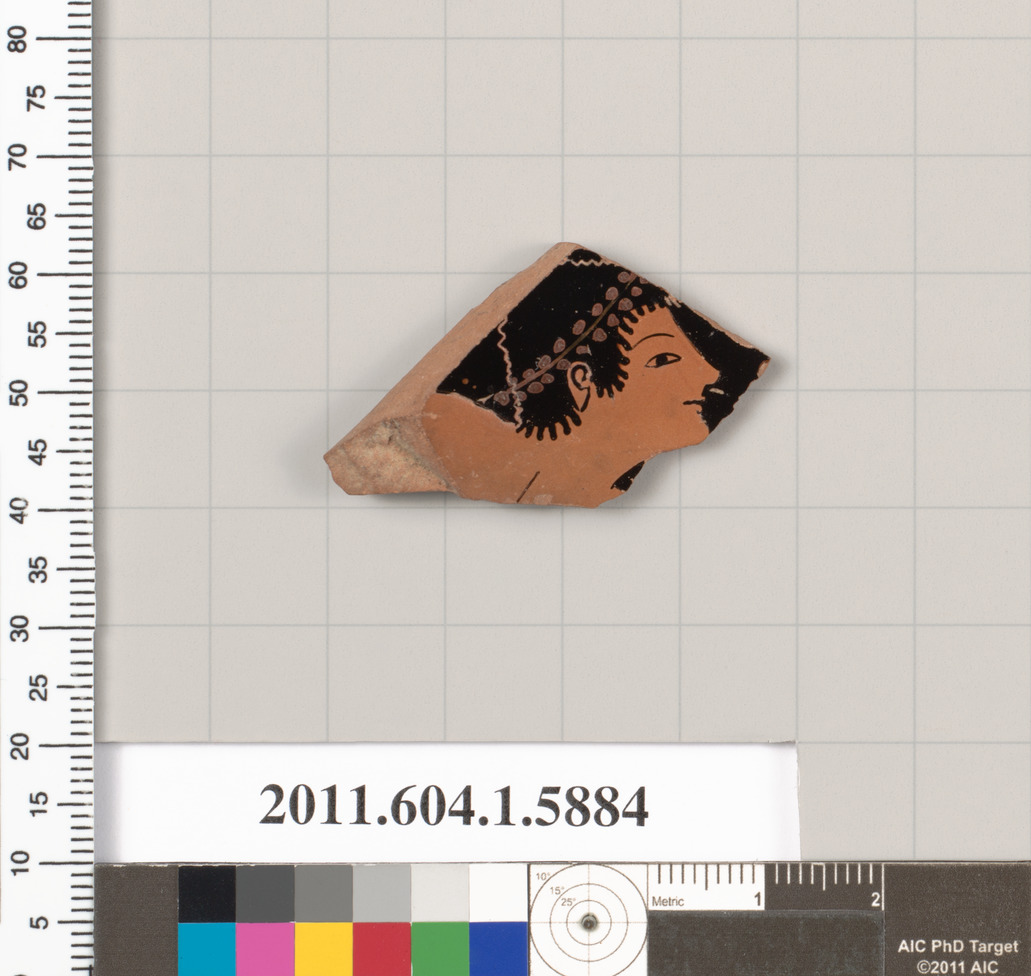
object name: kylix fragment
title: Terracotta fragment of a kylix (drinking cup)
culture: greek, attic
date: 520-510 BCE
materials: terracotta